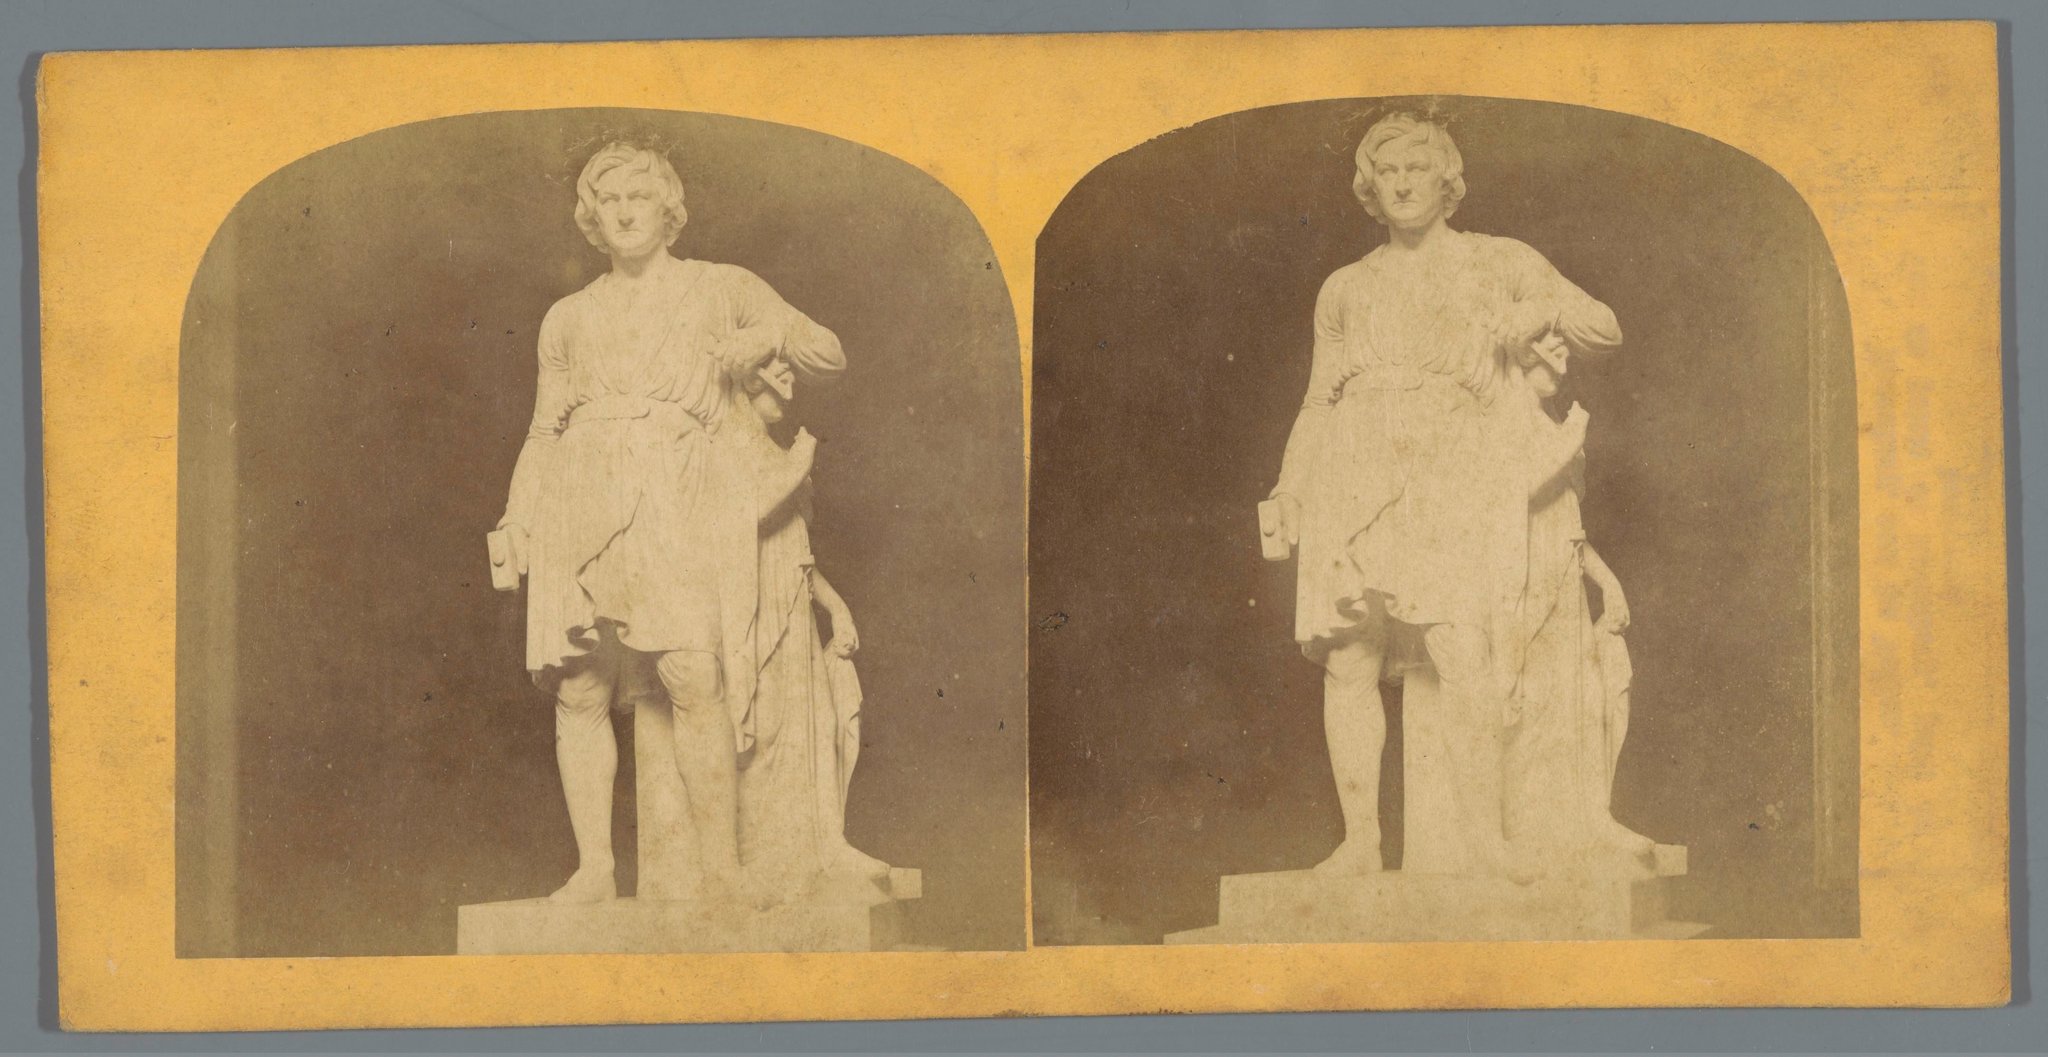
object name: stereograph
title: Zelfportret van Bertel Thorvaldsen en het standbeeld van hoop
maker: bertel thorvaldsen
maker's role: draughtsman, sculptor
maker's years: 1768-1844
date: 1862-1884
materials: cardboard, paper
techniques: albumen print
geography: copenhagen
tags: copenhagen (city), draughtsman, sculptor, bertel thorvaldsen, sculpture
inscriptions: inscription: ‘Original.’, number: ‘245.’, inscription: ‘7,-’, inscription: ‘Brevete Eneret’